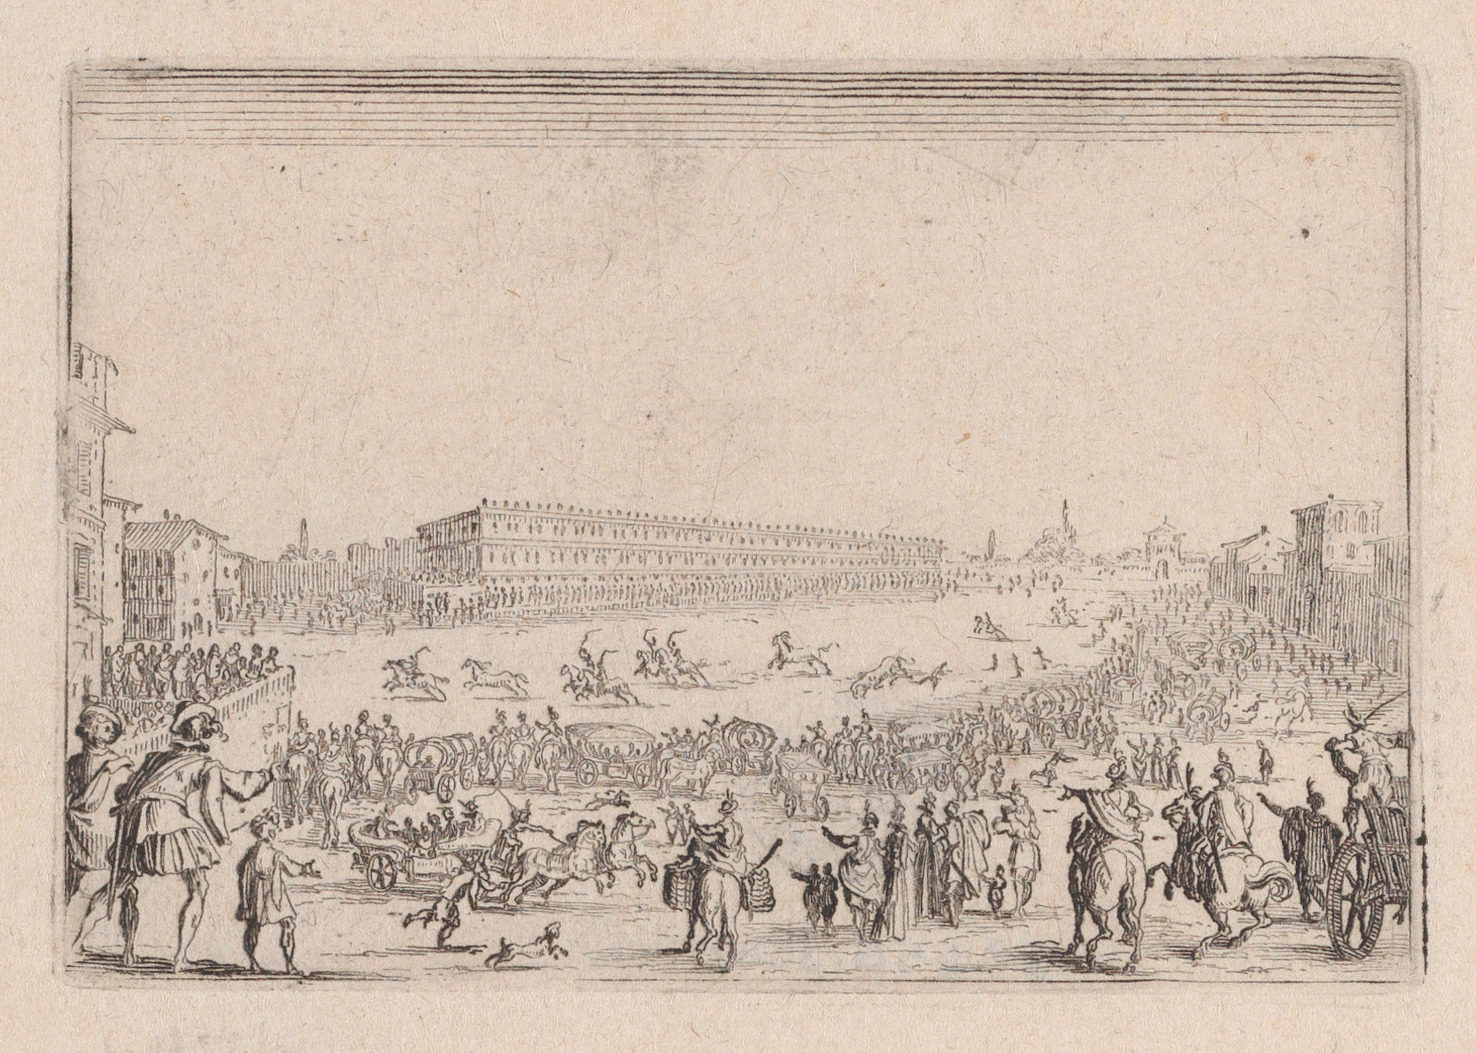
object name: print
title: La Course de Chevaux sur la Place Pitti a Florence (The Horse Race on the Piazza Pitti in Florence), from "Les Caprices" Series B, The Nancy Set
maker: jacques callot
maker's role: artist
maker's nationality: french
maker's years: 1592-1635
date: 1617-1620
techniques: etching